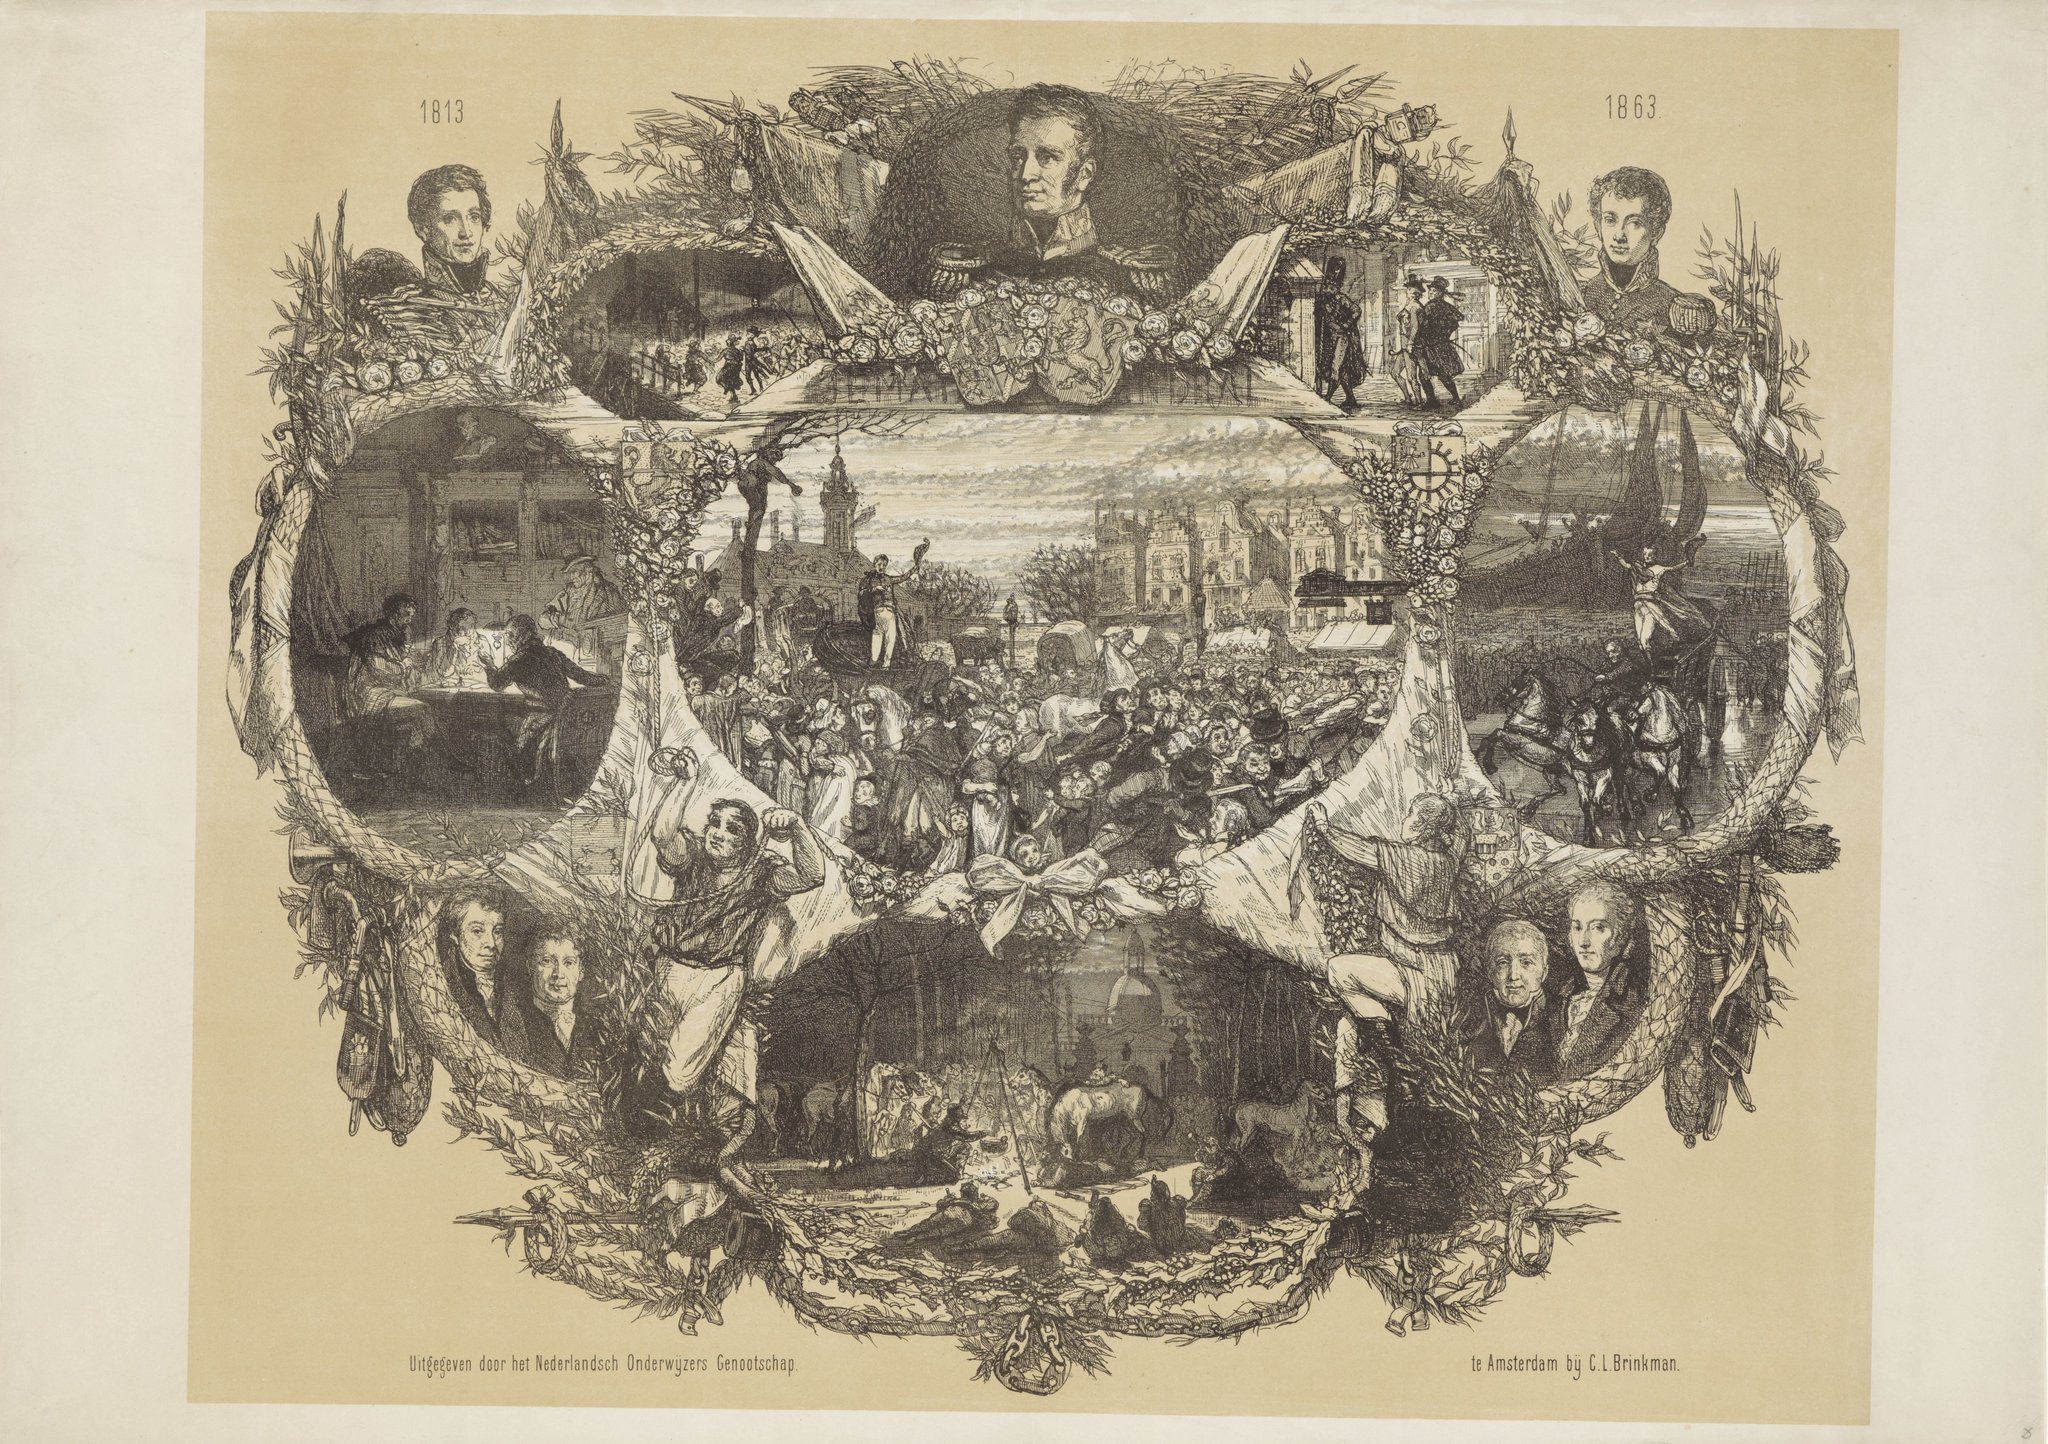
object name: print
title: Gedenkplaat bij de novemberfeesten in 1863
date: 1863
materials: paper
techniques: tone lithography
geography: netherlands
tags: the hague, berlin, william i of the netherlands, triumphal entry and public reception, pageant, 'entrée solennelle', 'joyeuse entrée', historical persons, amsterdam, landing of william frederick i (1813)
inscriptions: collector's mark: Lugt 2228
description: Gedenkplaat bij de nationale feestviering van vijftig jaar Nederlandse onafhankelijkheid 1813-1863, in november 1863. Centraal de aankomst van koning Willem I in Amsterdam voor de inhuldiging in 1813. Onderaan het bivak van de Kozakken bij de Muiderpoort in Amsterdam, links de vergadering van het driemanschap, rechts de landing van Willem I in Scheveningen. Rondom andere scènes, guirlandes, wapens en portretten.